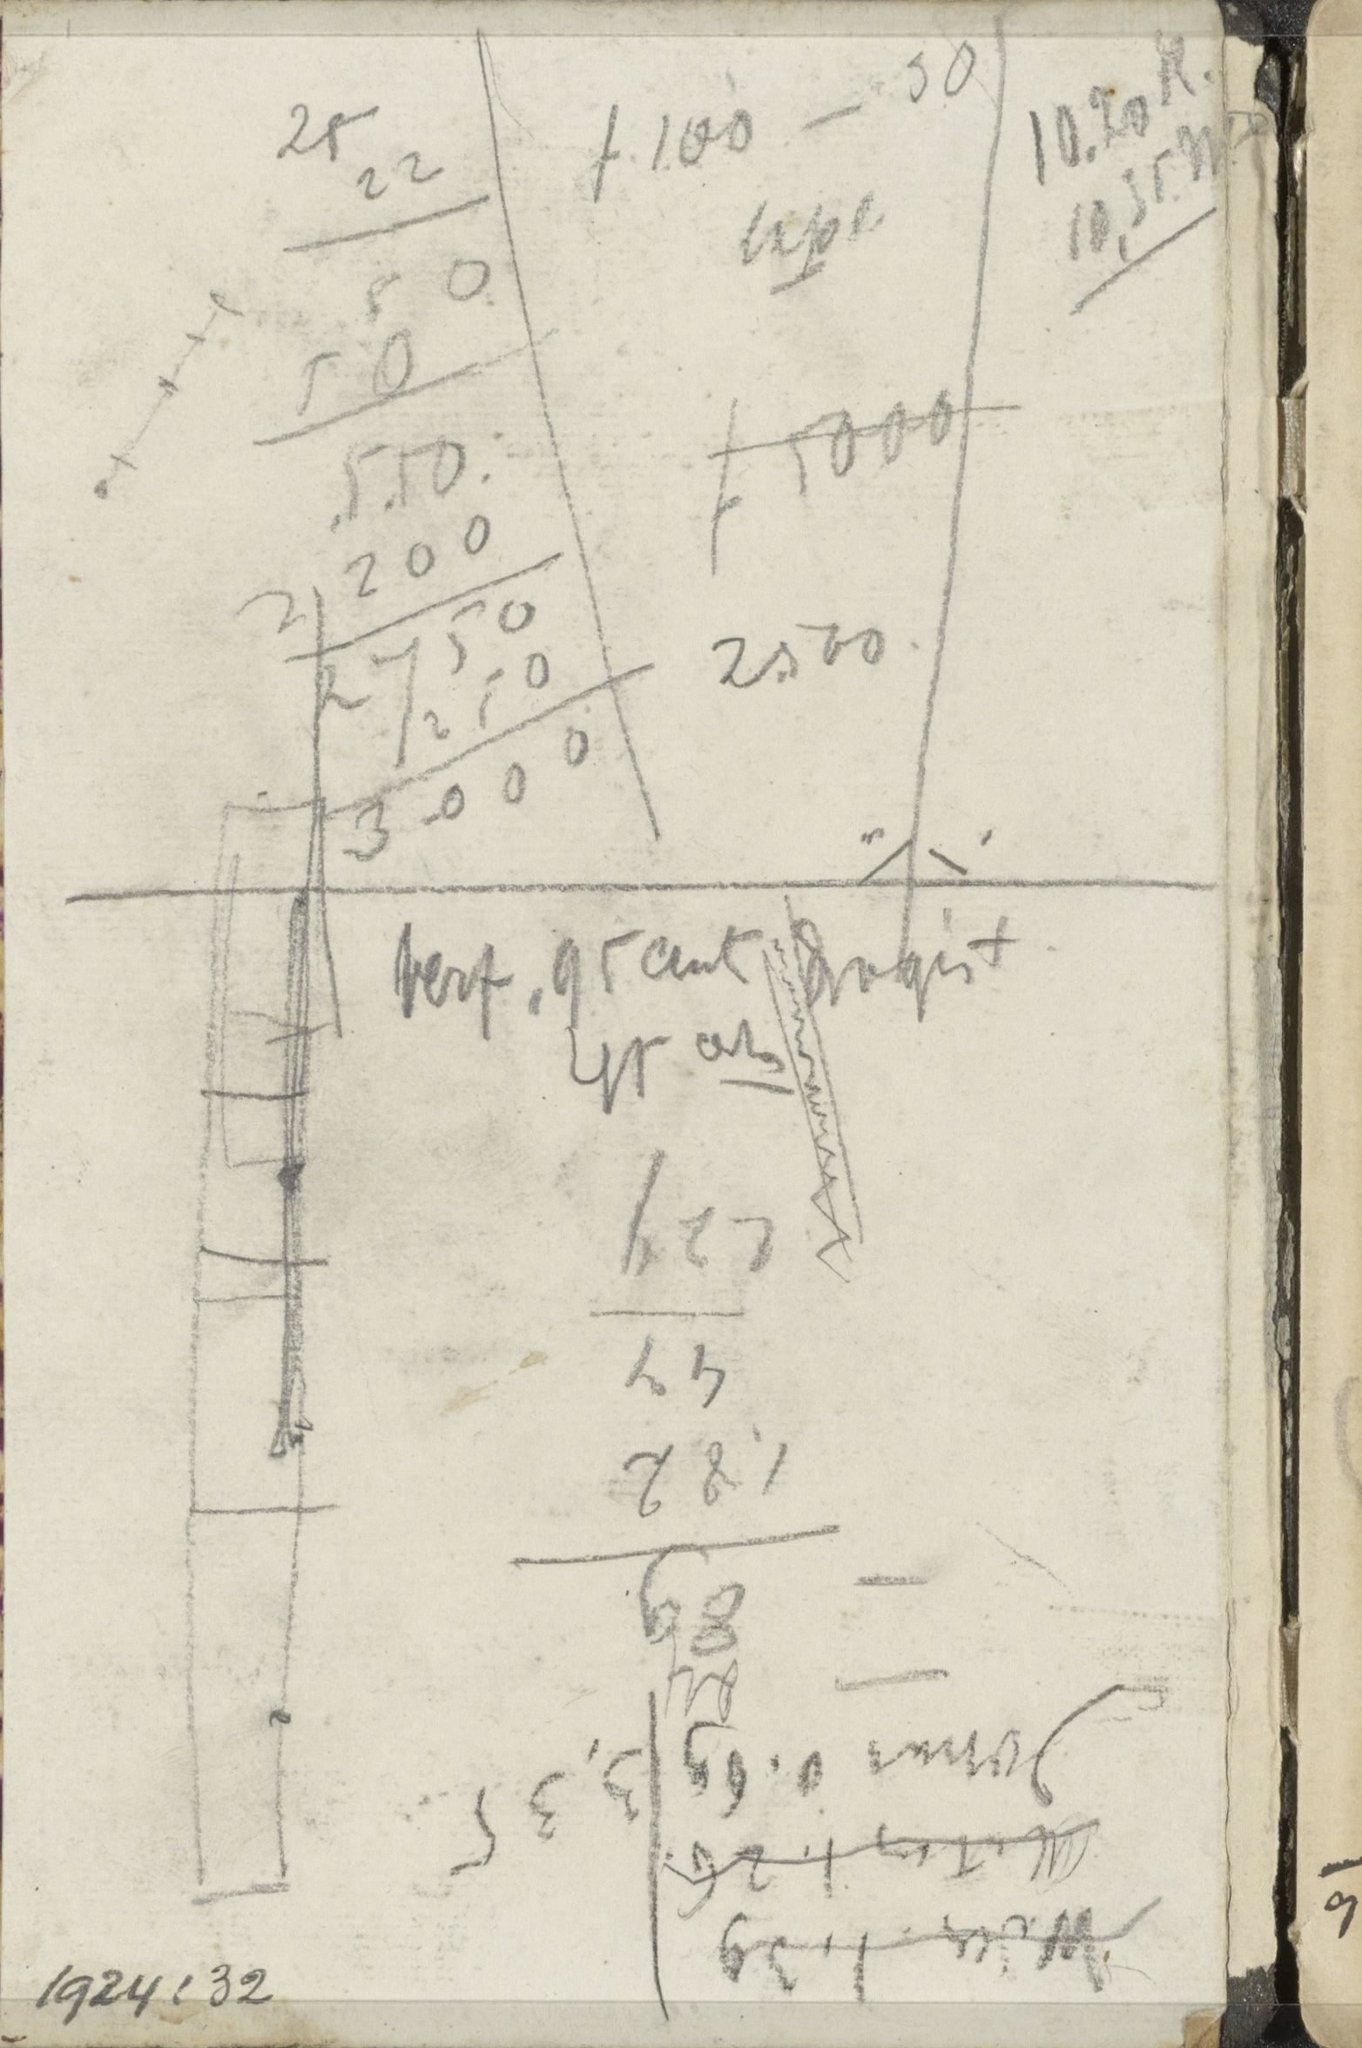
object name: endleaf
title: Studie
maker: george hendrik breitner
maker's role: draughtsman, painter, print maker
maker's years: 1857-1923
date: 1886-1923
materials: chalk, paper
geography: amsterdam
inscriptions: annotation: ‘[...]’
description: Pagina 1, voorste schutblad, uit een schetsboek met 14 bladen.